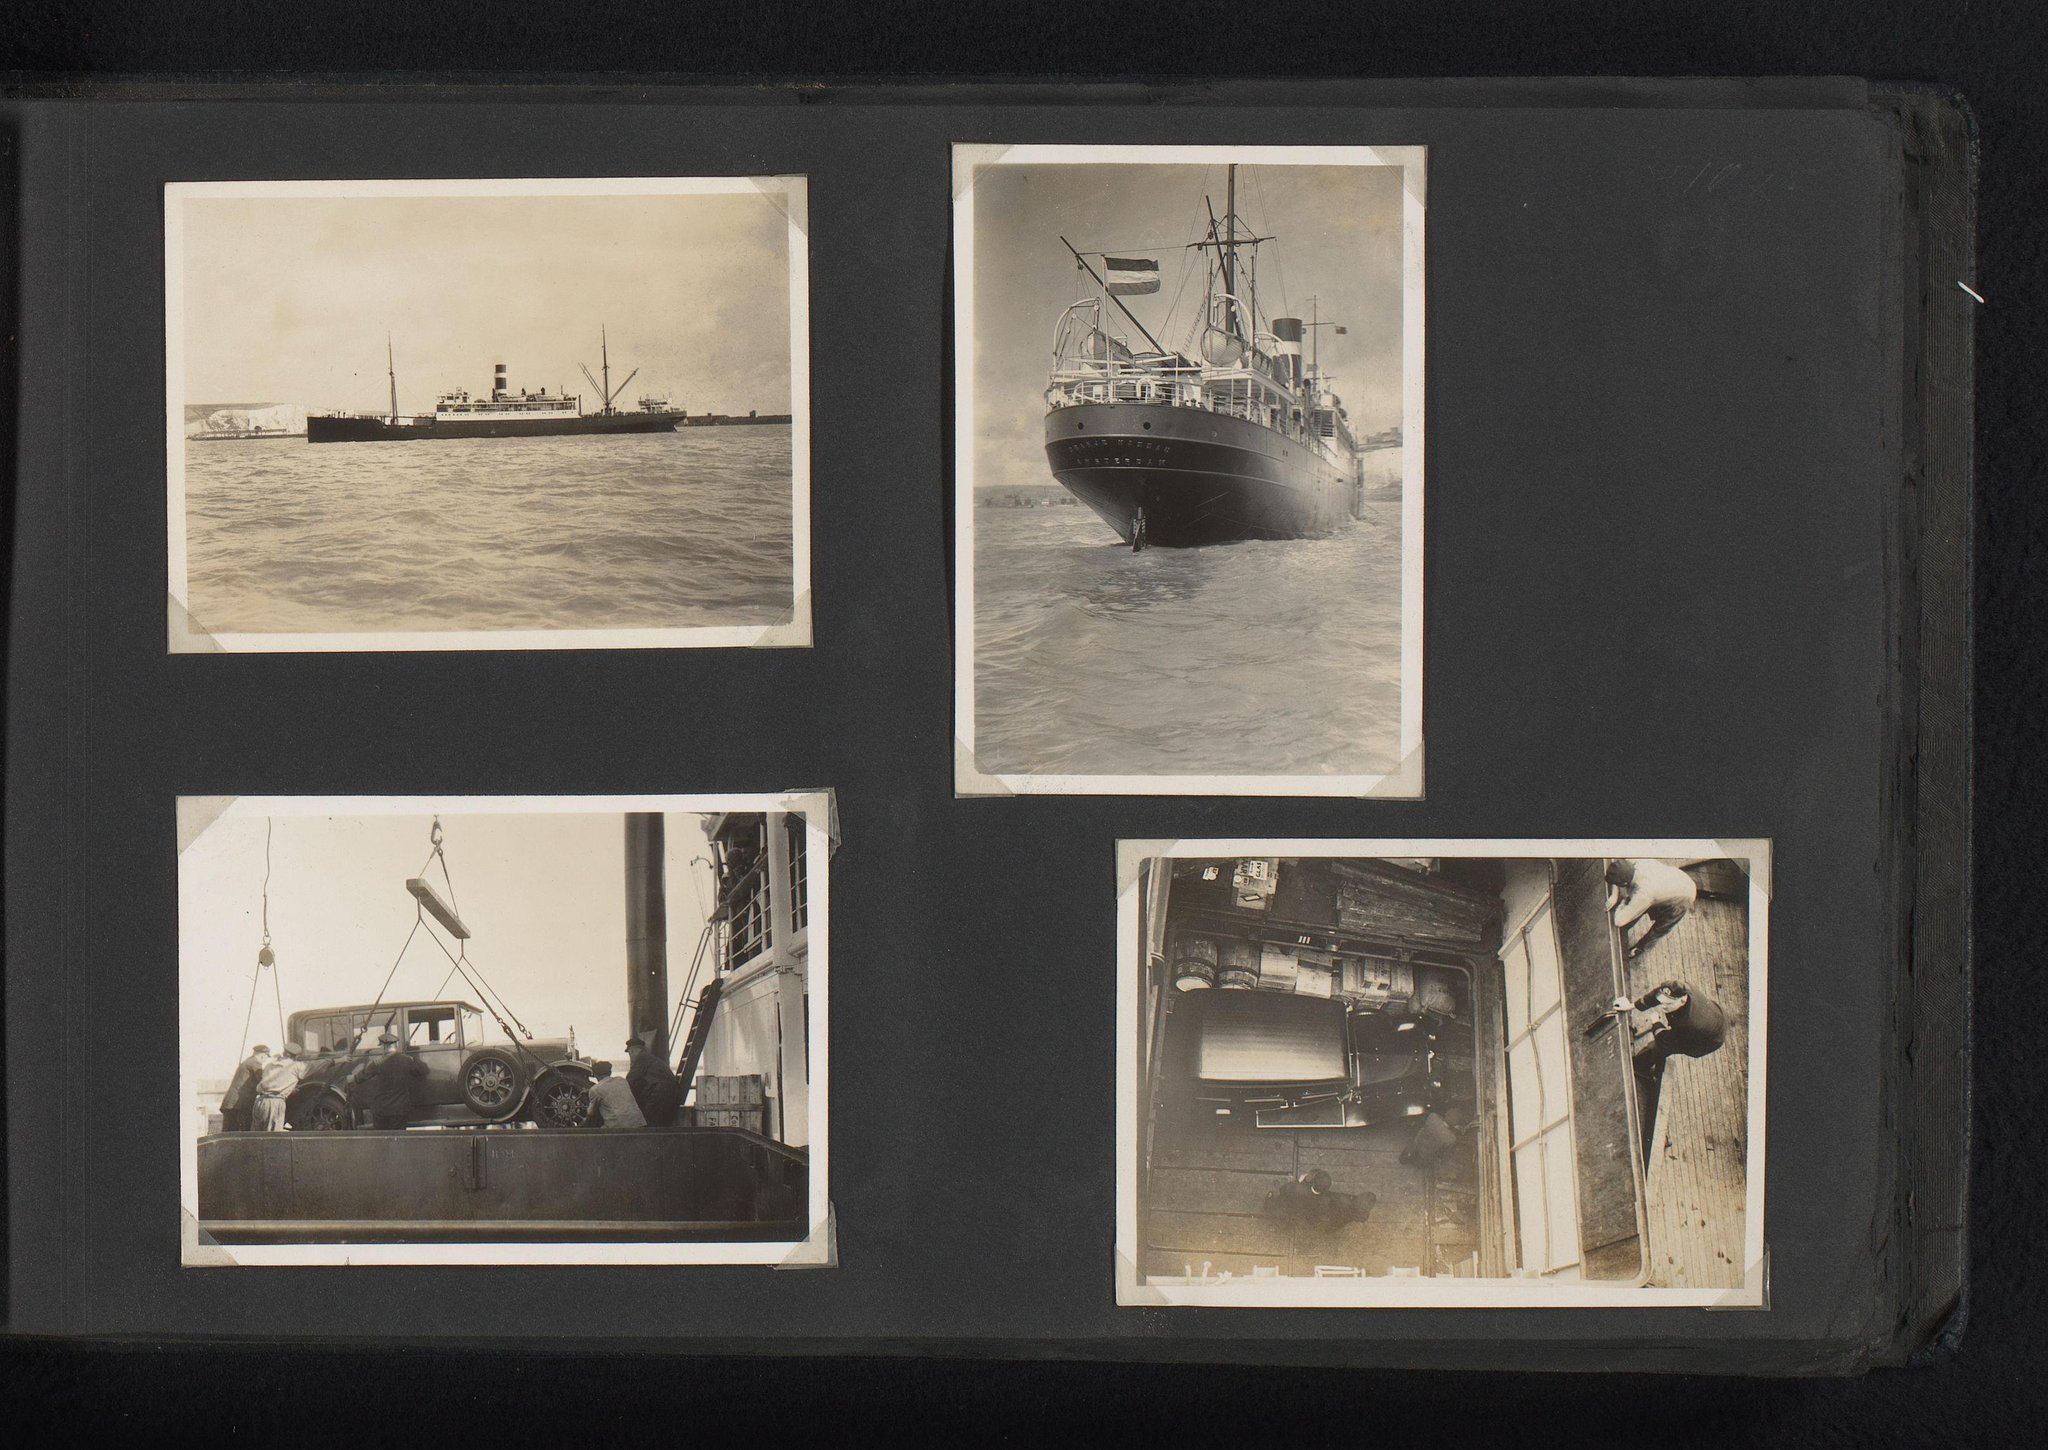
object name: album leaf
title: Vier foto's van een scheepsreis met de Oranje Nassau naar Madeira, ter ere van het zilveren huwelijksjubileum van Hendrik Herman van den Berg en Caroline Louise van den Berg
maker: frank willem van den berg (1912-1998)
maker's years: 1912-1998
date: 1933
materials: paper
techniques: gelatin silver print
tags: steamship, motorship, atlantic ocean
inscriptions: inscription: ‘I. Oranje Nassau K.N.S.M.’, number: ‘10 75’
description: Deze foto's maken deel uit van een album.